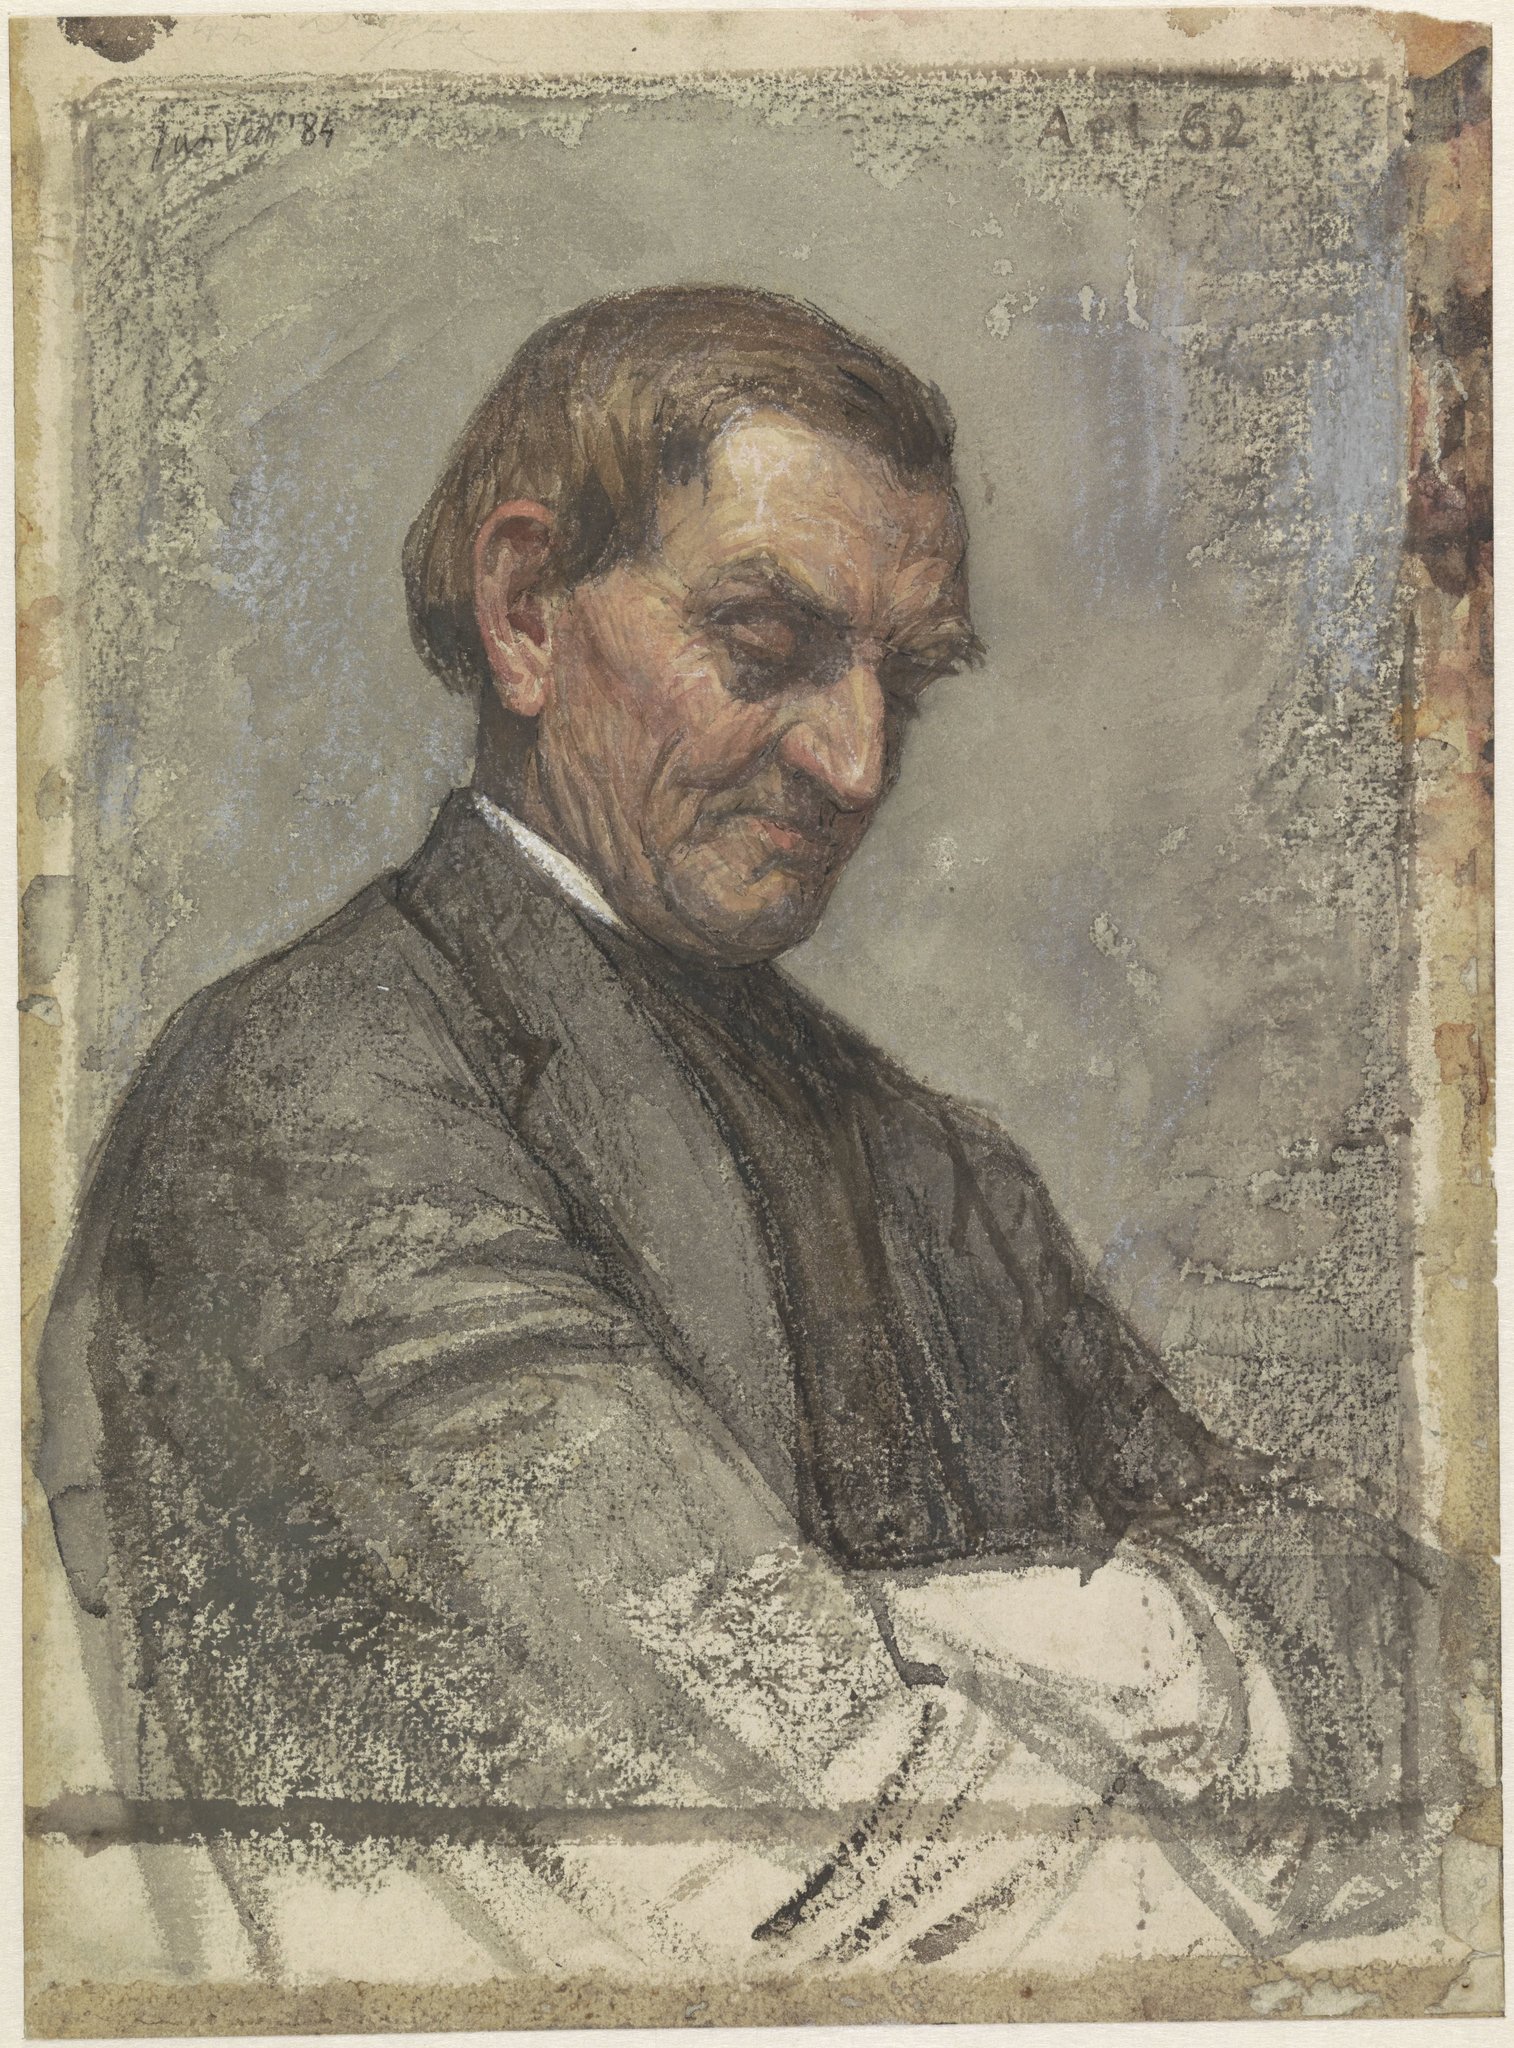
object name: watercolor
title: Portret van een man, met neergeslagen blik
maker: jan veth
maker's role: designer, draughtsman, painter, print maker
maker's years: 1864-1925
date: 1884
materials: chalk, paper, watercolor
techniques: brush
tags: anonymous historical person portrayed alone